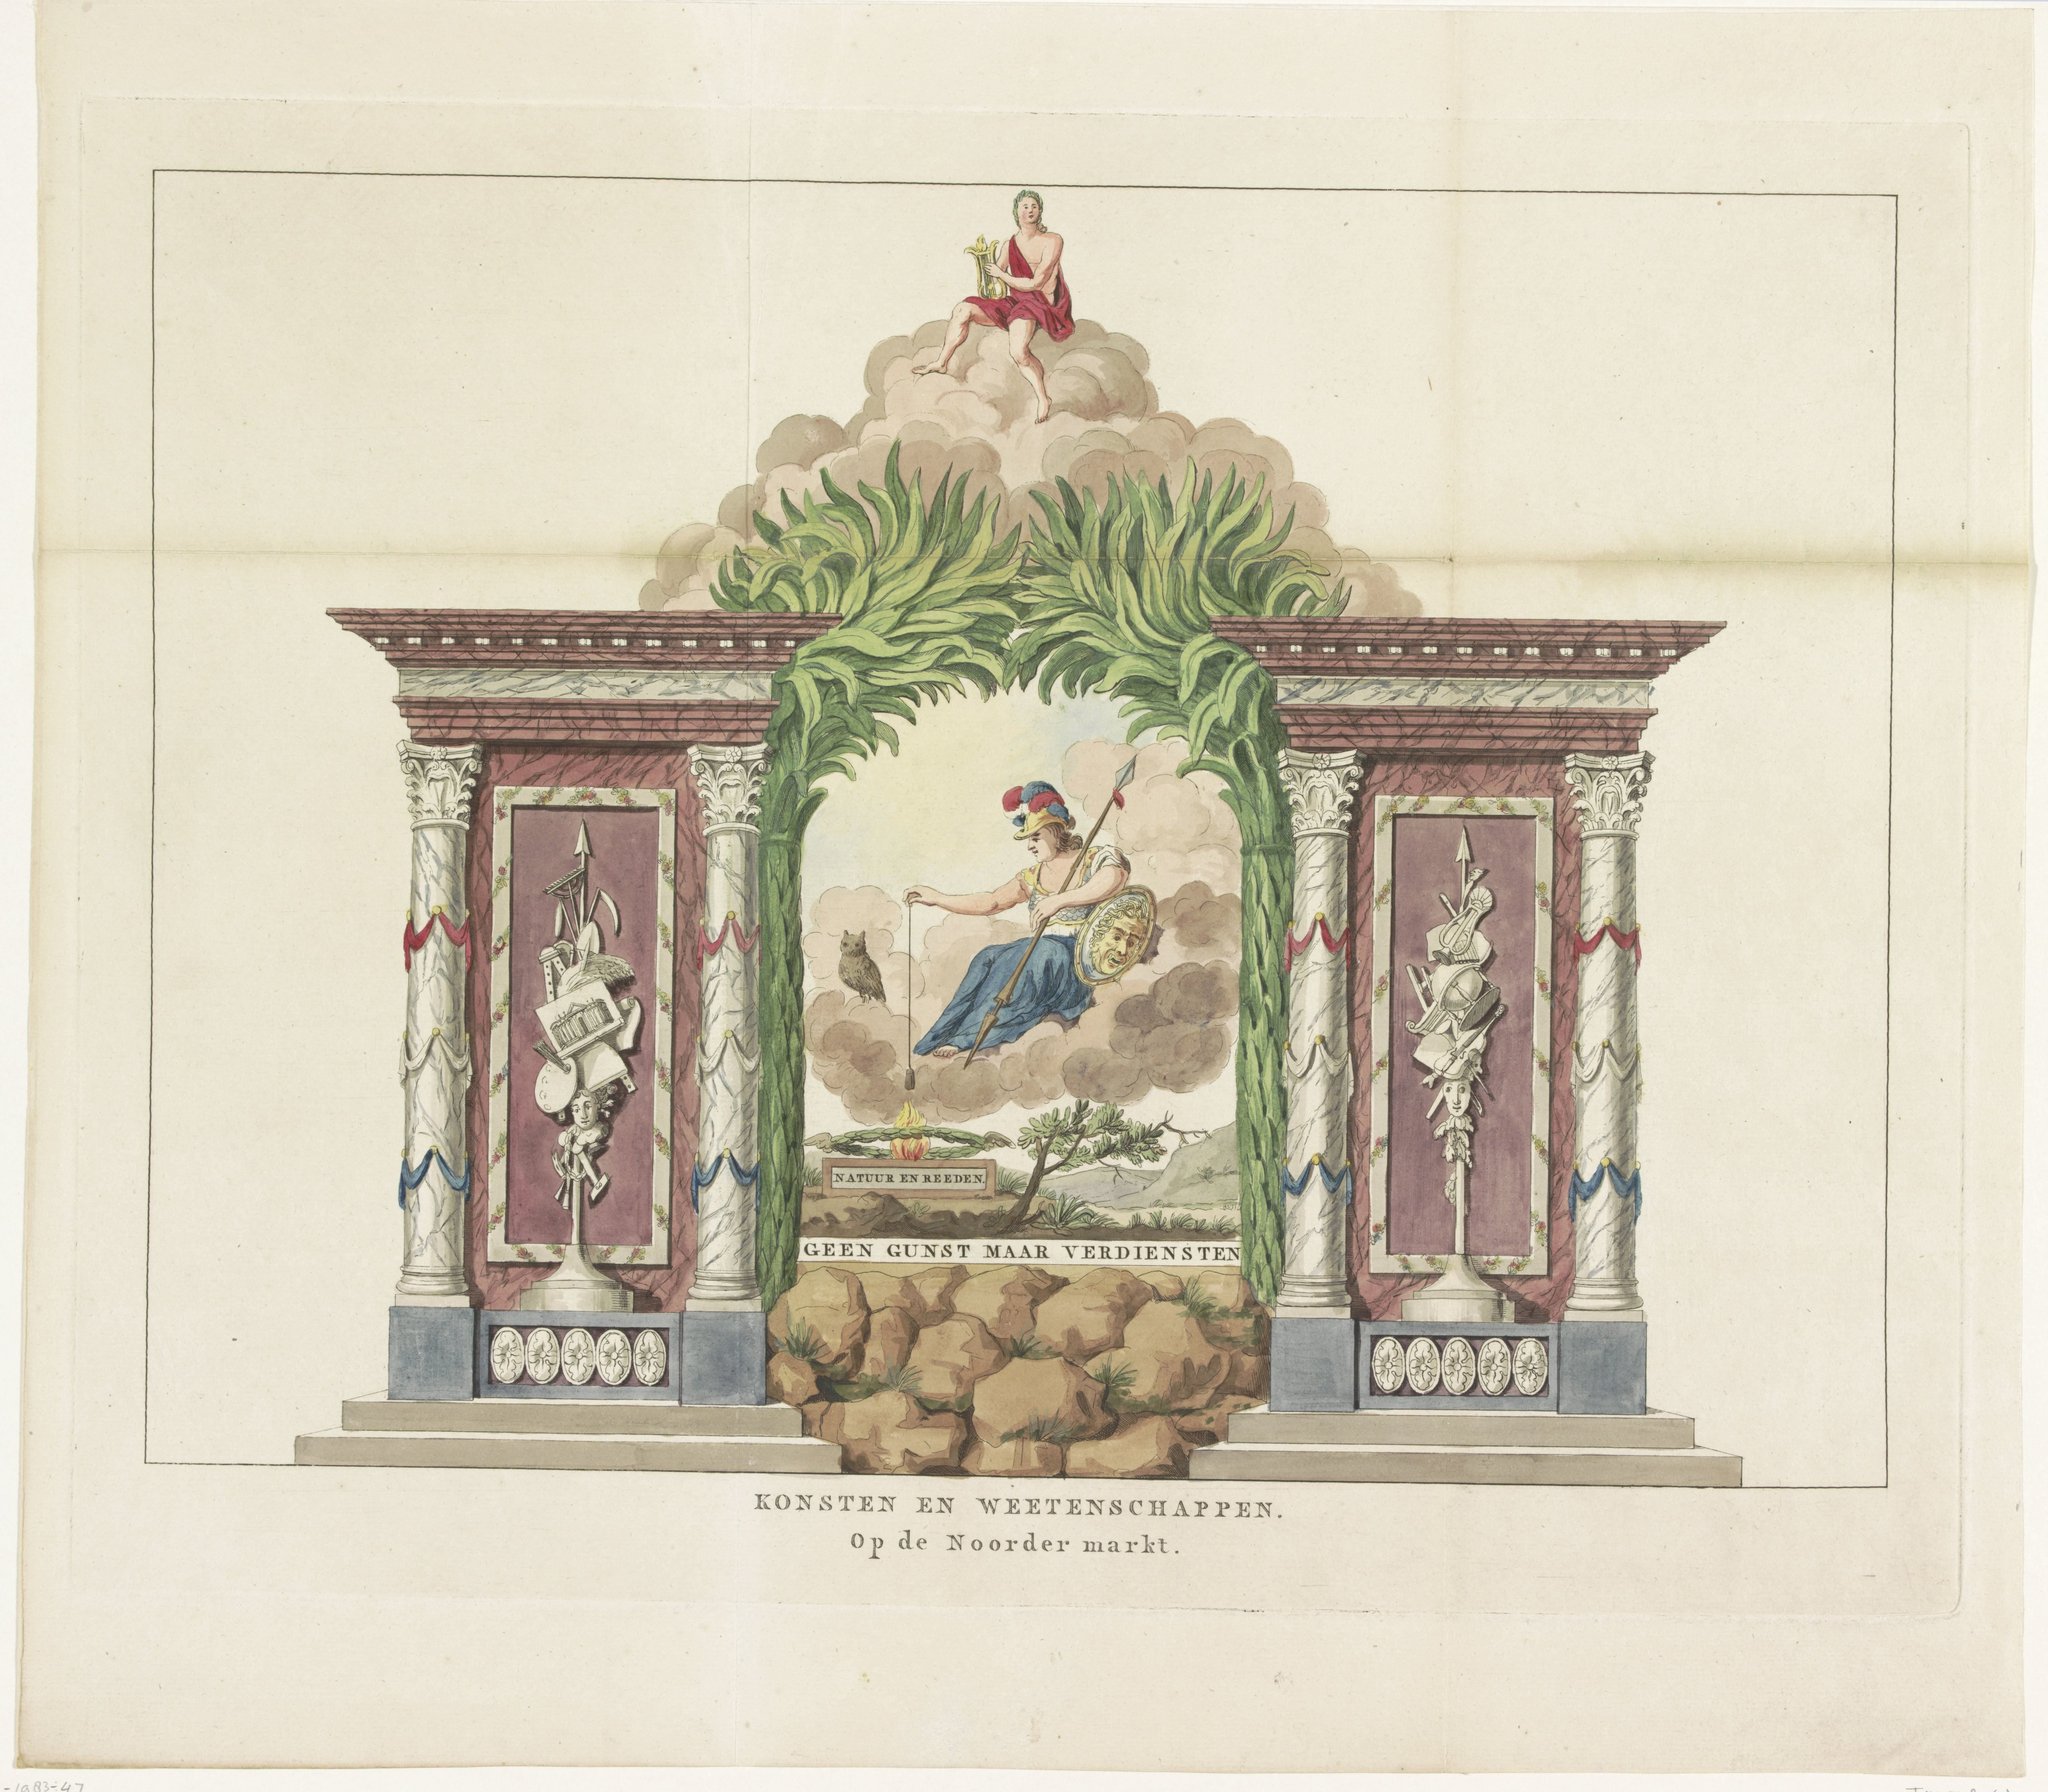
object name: print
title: Konsten en Weetenschappen. Op de Noordermarkt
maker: Anonymous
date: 1795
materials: paper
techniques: etching, hand coloring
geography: netherlands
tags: specific aspects, allegorical aspects of minerva; minerva as patroness, festivities on events of national importance (+ festive decoration ~ festive activities), equality, equity, fairness, righteousness; 'equalità', 'equità', 'giuditio giusto', 'ordine dritto e giusto', 'ugualità' (ripa) (+ symbolical representation of concept), amsterdam, alliance with france (1795)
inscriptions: collector's mark: Lugt 2760, collector's mark: Lugt 2228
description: Kunsten en Wetenschappen, allegorische decoratie opgericht op de Noordermarkt te Amsterdam bij het Alliantiefeest op 19 juni 1795. Minerva zittend in de wolken met schietlood (Gelijkheid) boven een krans en vuur. Bovenaan Apollo spelend op de lier.